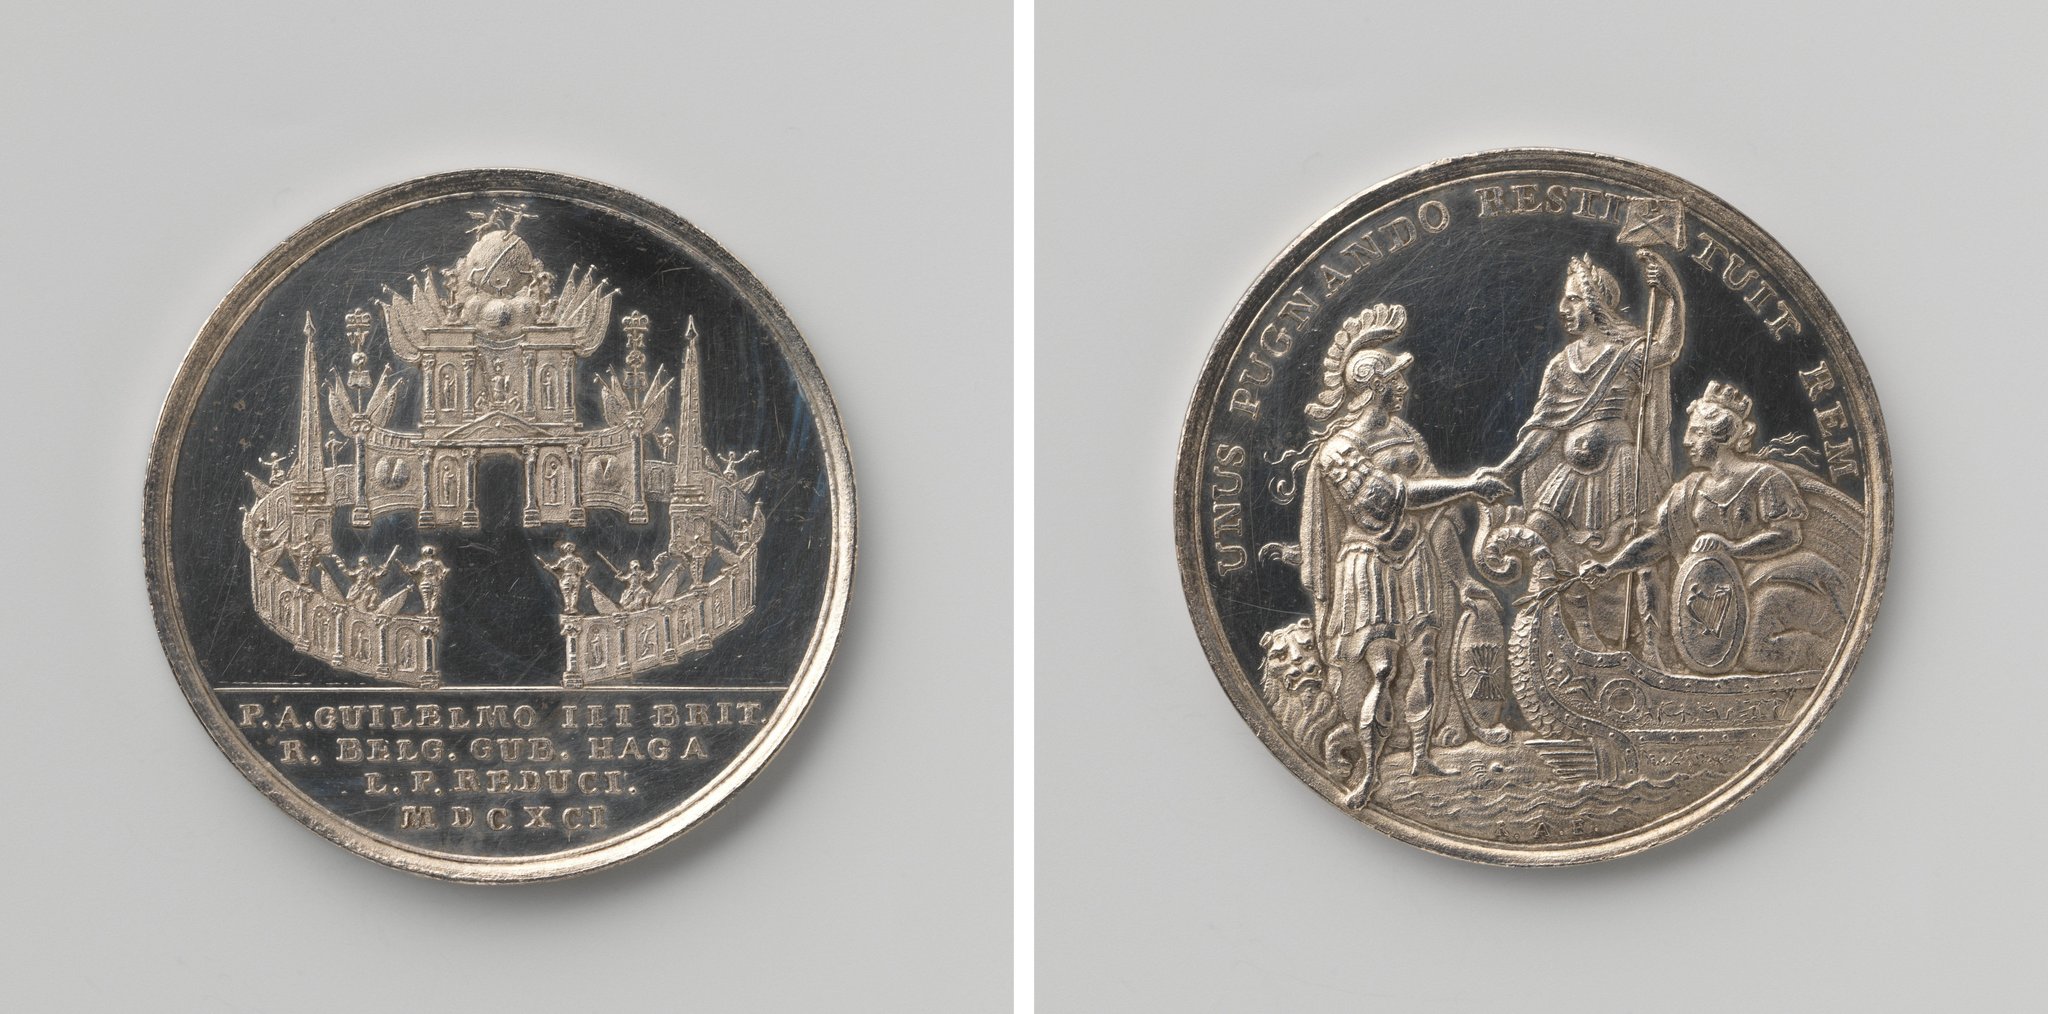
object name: history medal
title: Zegevierende intocht van Willem III te 's-Gravenhage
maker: reynier arondeaux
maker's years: 1678-1727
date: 1691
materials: silver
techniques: striking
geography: amsterdam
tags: william iii (prince of orange and king of england, scotland, and ireland), the hague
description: Zilveren penning. Voorzijde: versieringen op de Grote Markt; afsnede: opschrift. Keerzijde: Willem III gekleed als Romeins keizer met XP-standaard en vergezeld van Ierland in sloep wordt door Holland met leeuw verwelkomd binnen omschrift